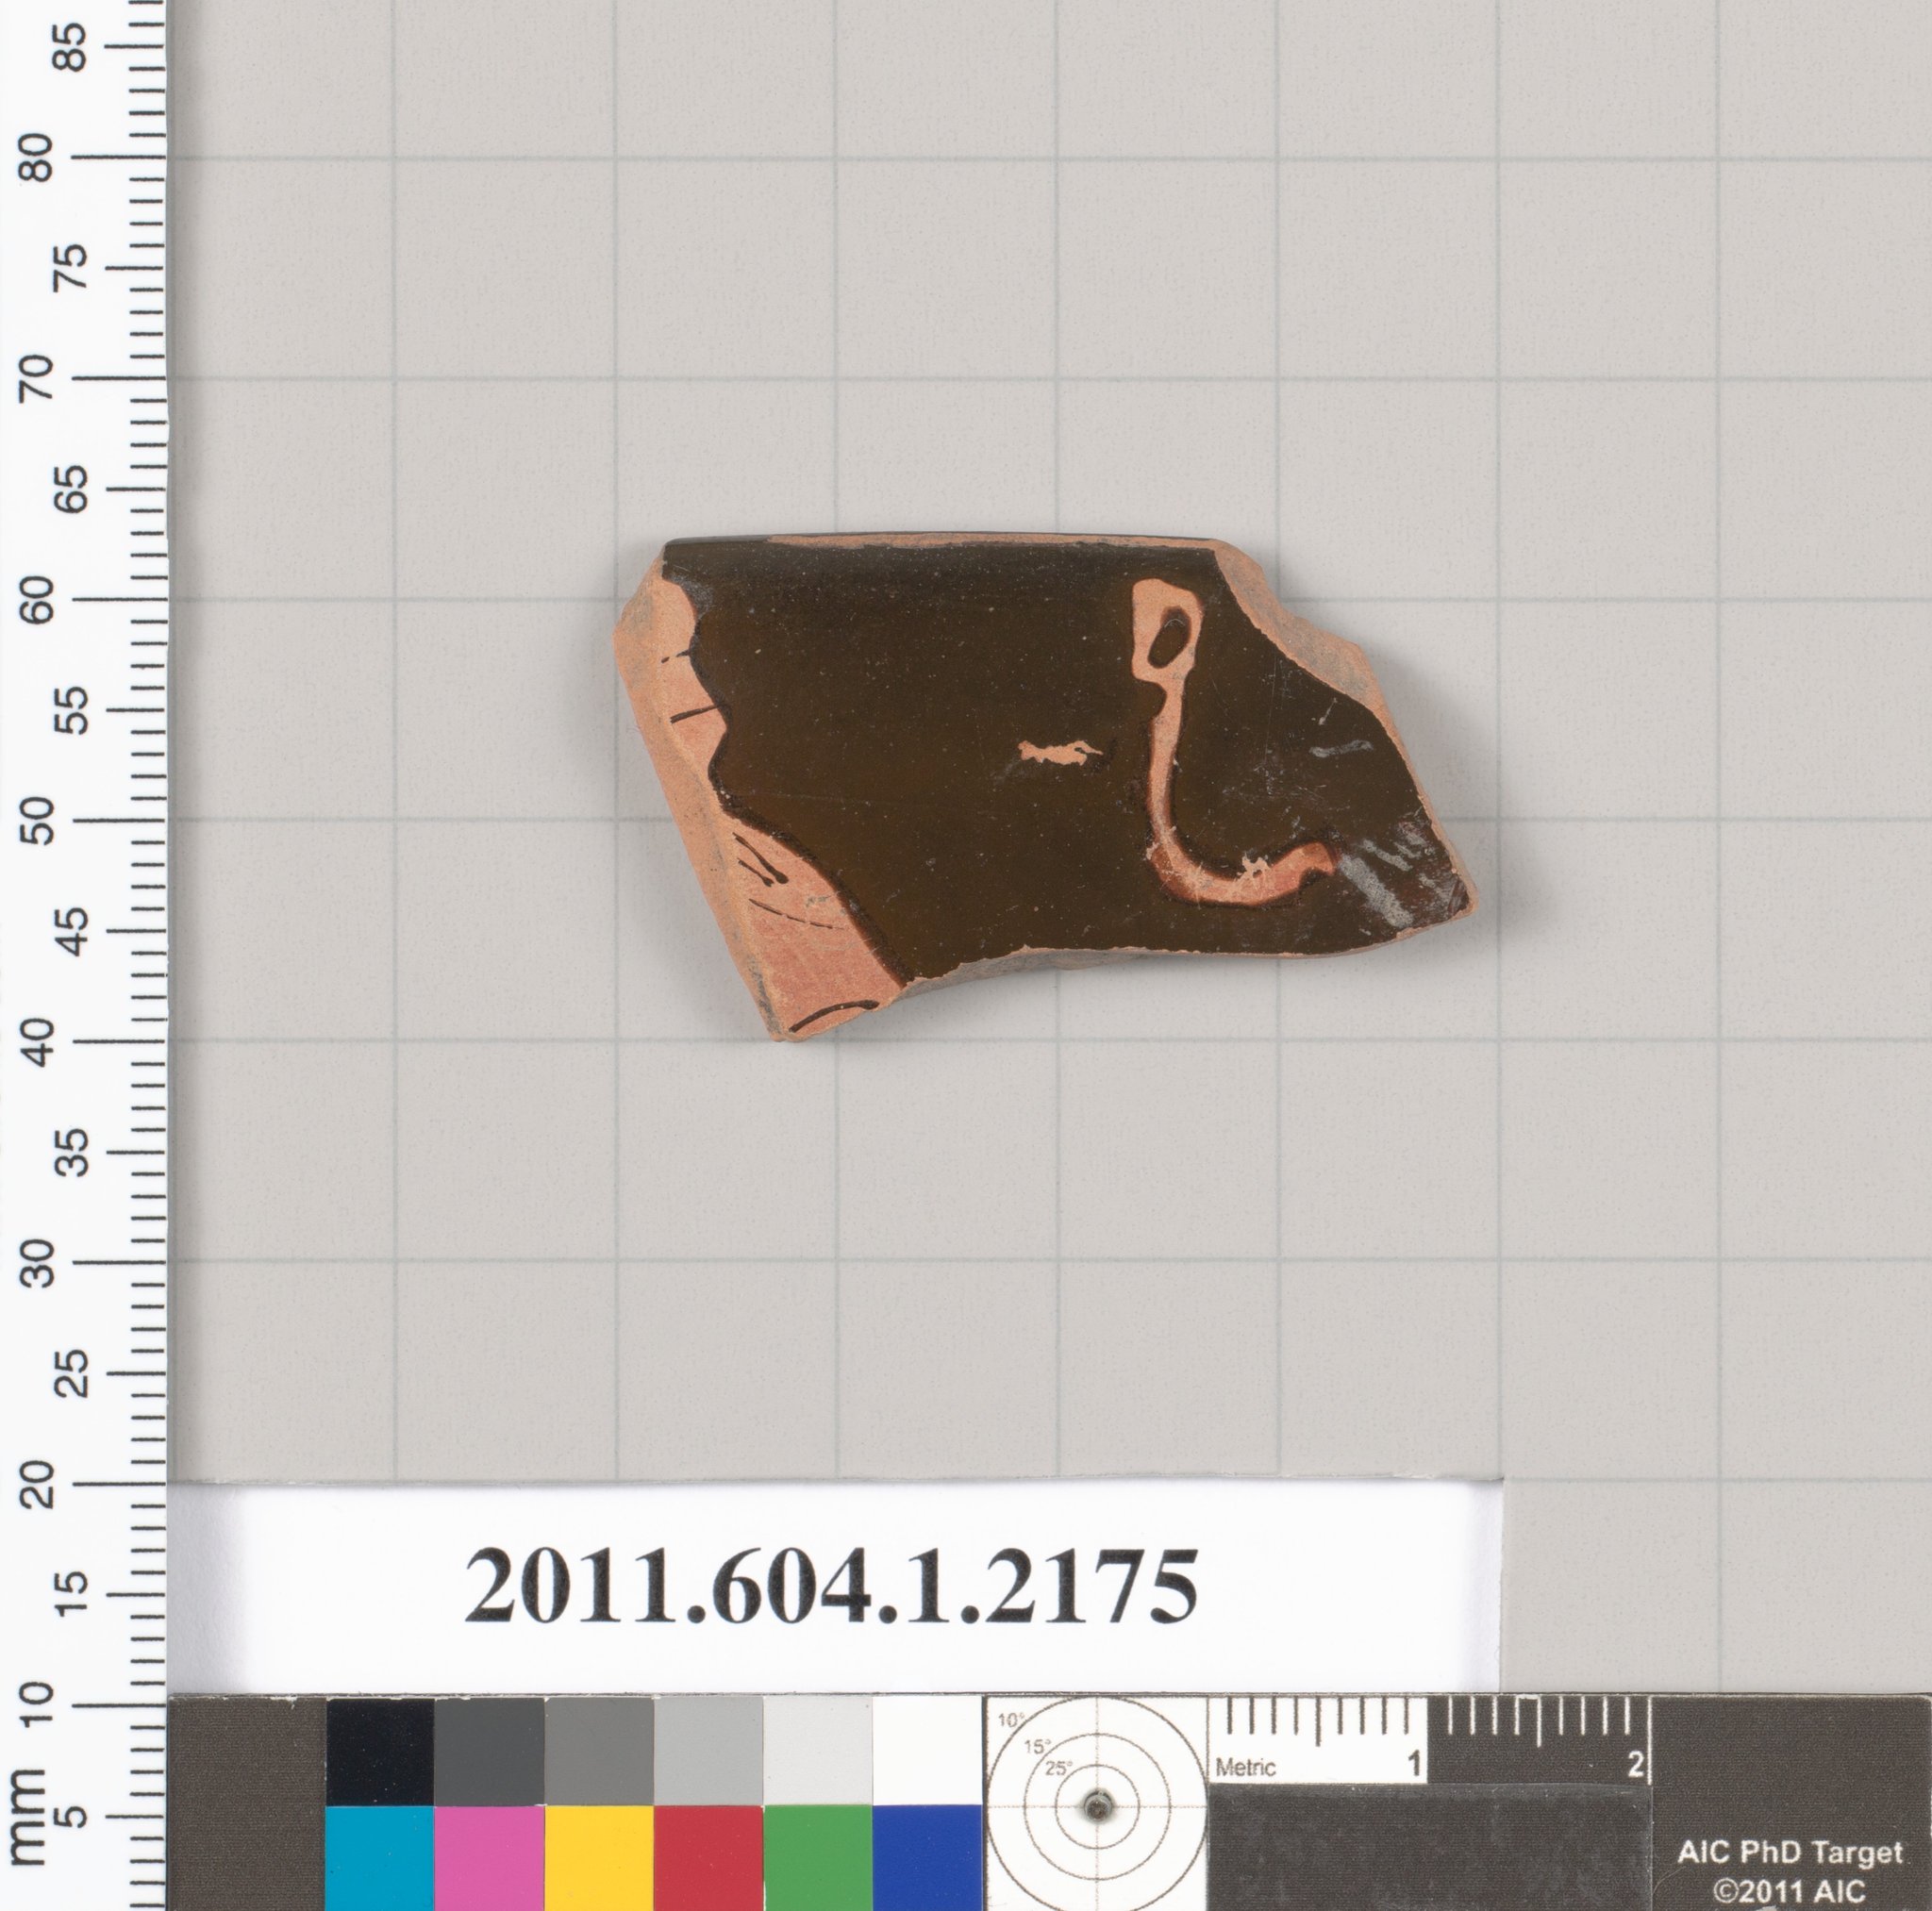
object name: kylix fragment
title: Terracotta rim fragment of a kylix (drinking cup)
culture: greek, attic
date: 467-435 BCE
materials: terracotta